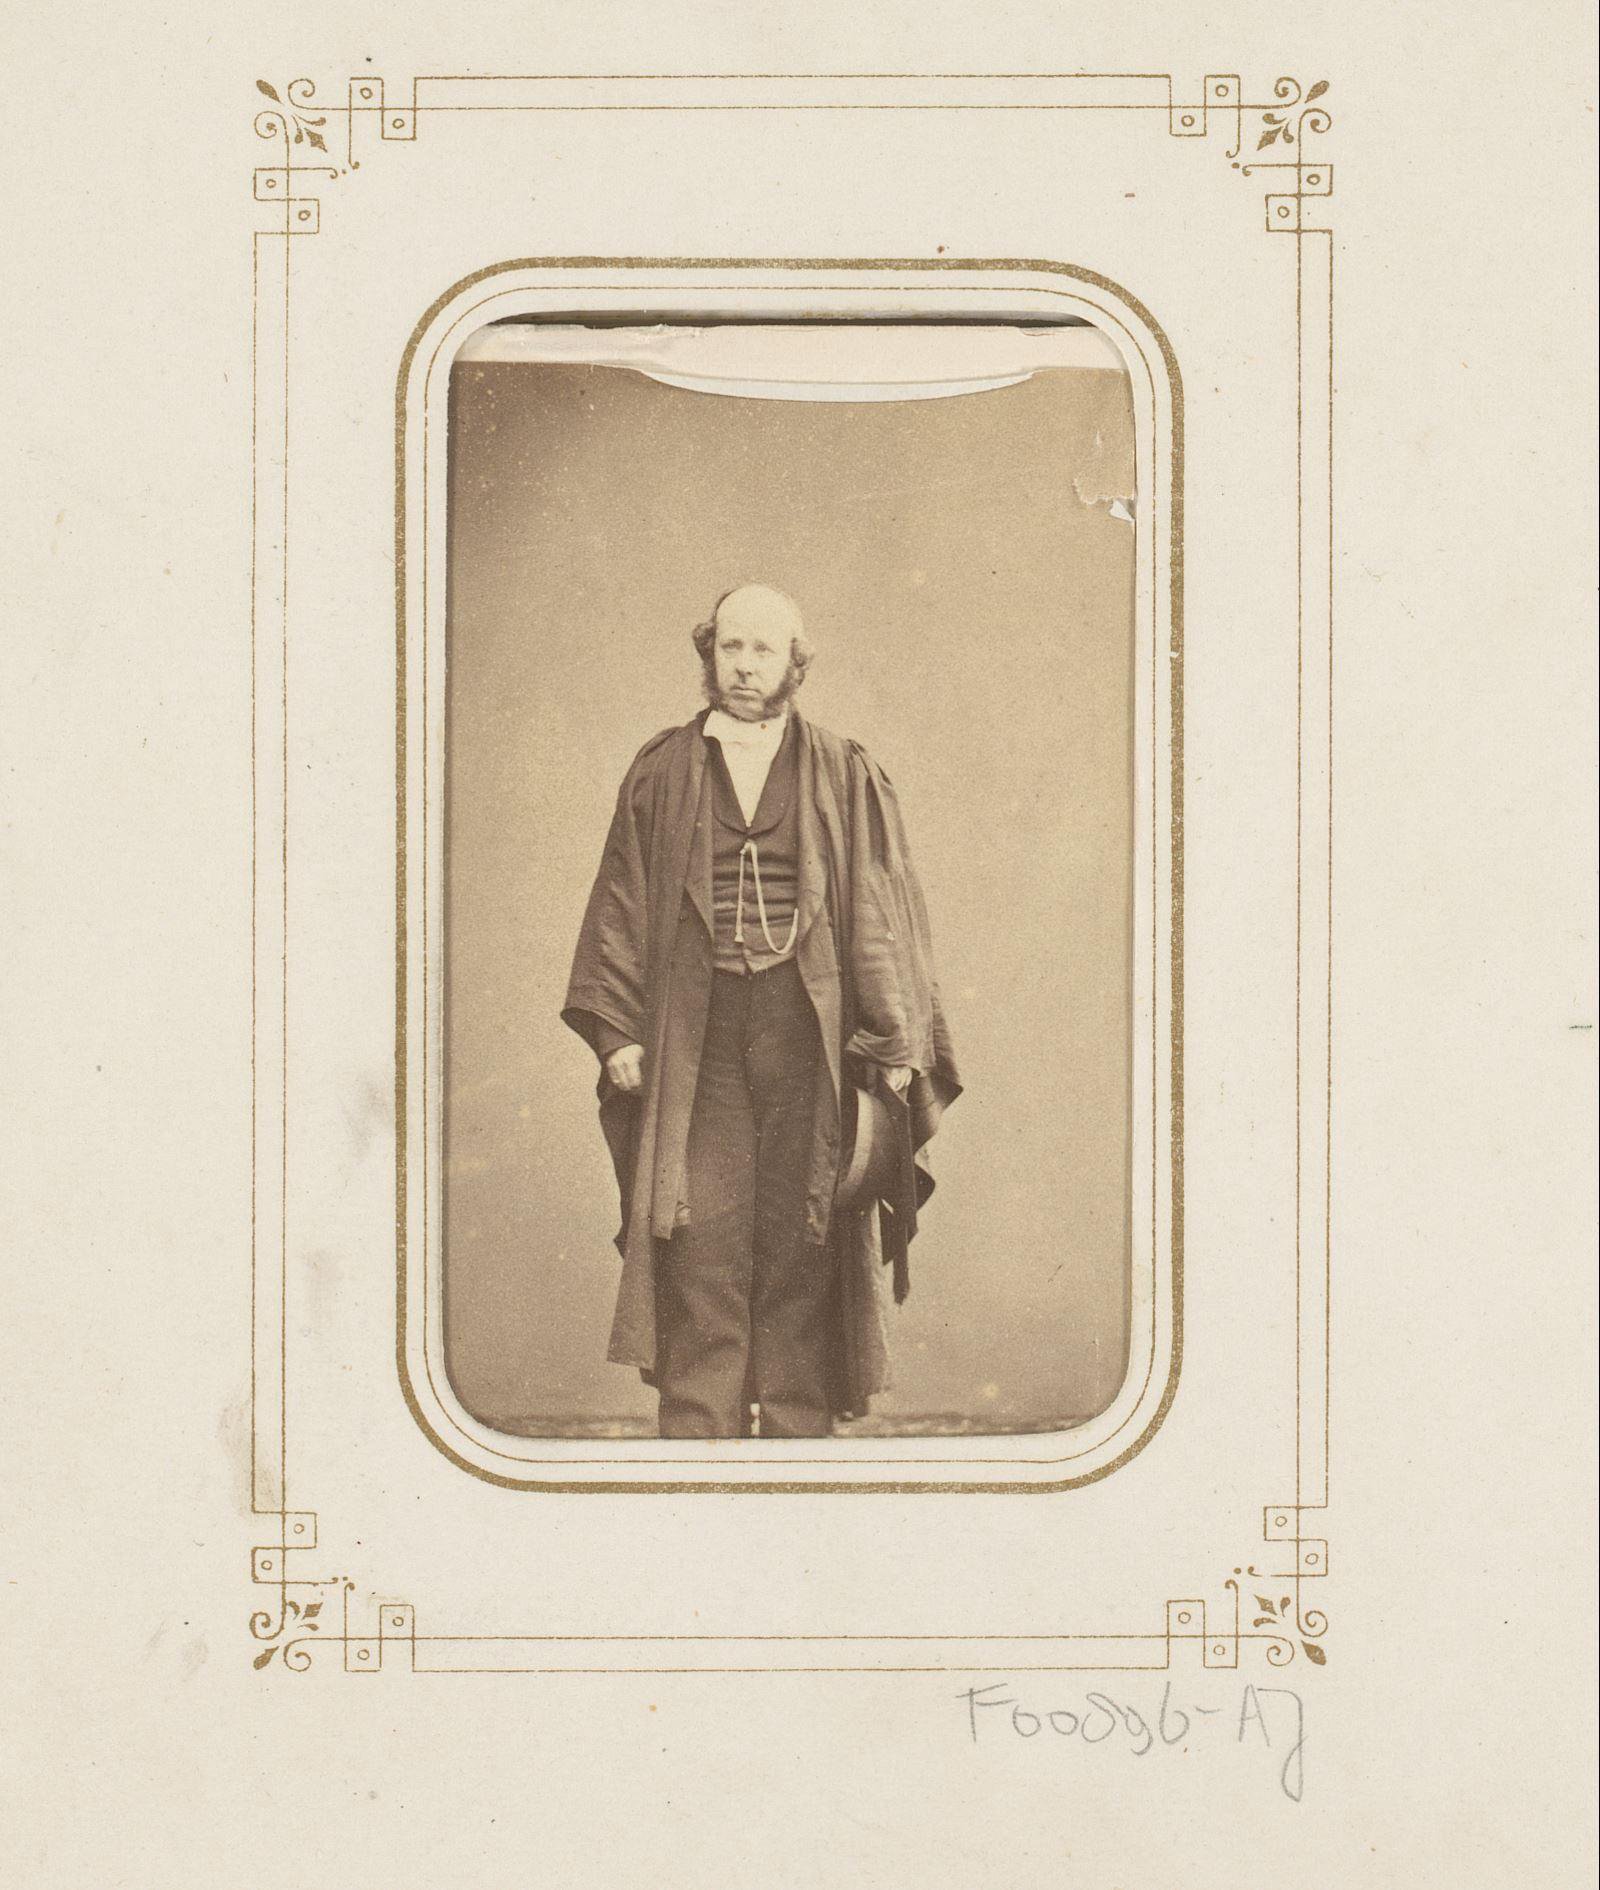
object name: photograph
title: Portret van een man met bakkenbaarden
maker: s.j. wiseman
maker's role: fotograaf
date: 1855-1890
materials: cardboard, photographic support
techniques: albumen print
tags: standing figure, sideburns, adult man, historical persons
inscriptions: inscription: ‘Photographed by/ S.J. Wiseman S. Bernard St./ Southampton(...)’